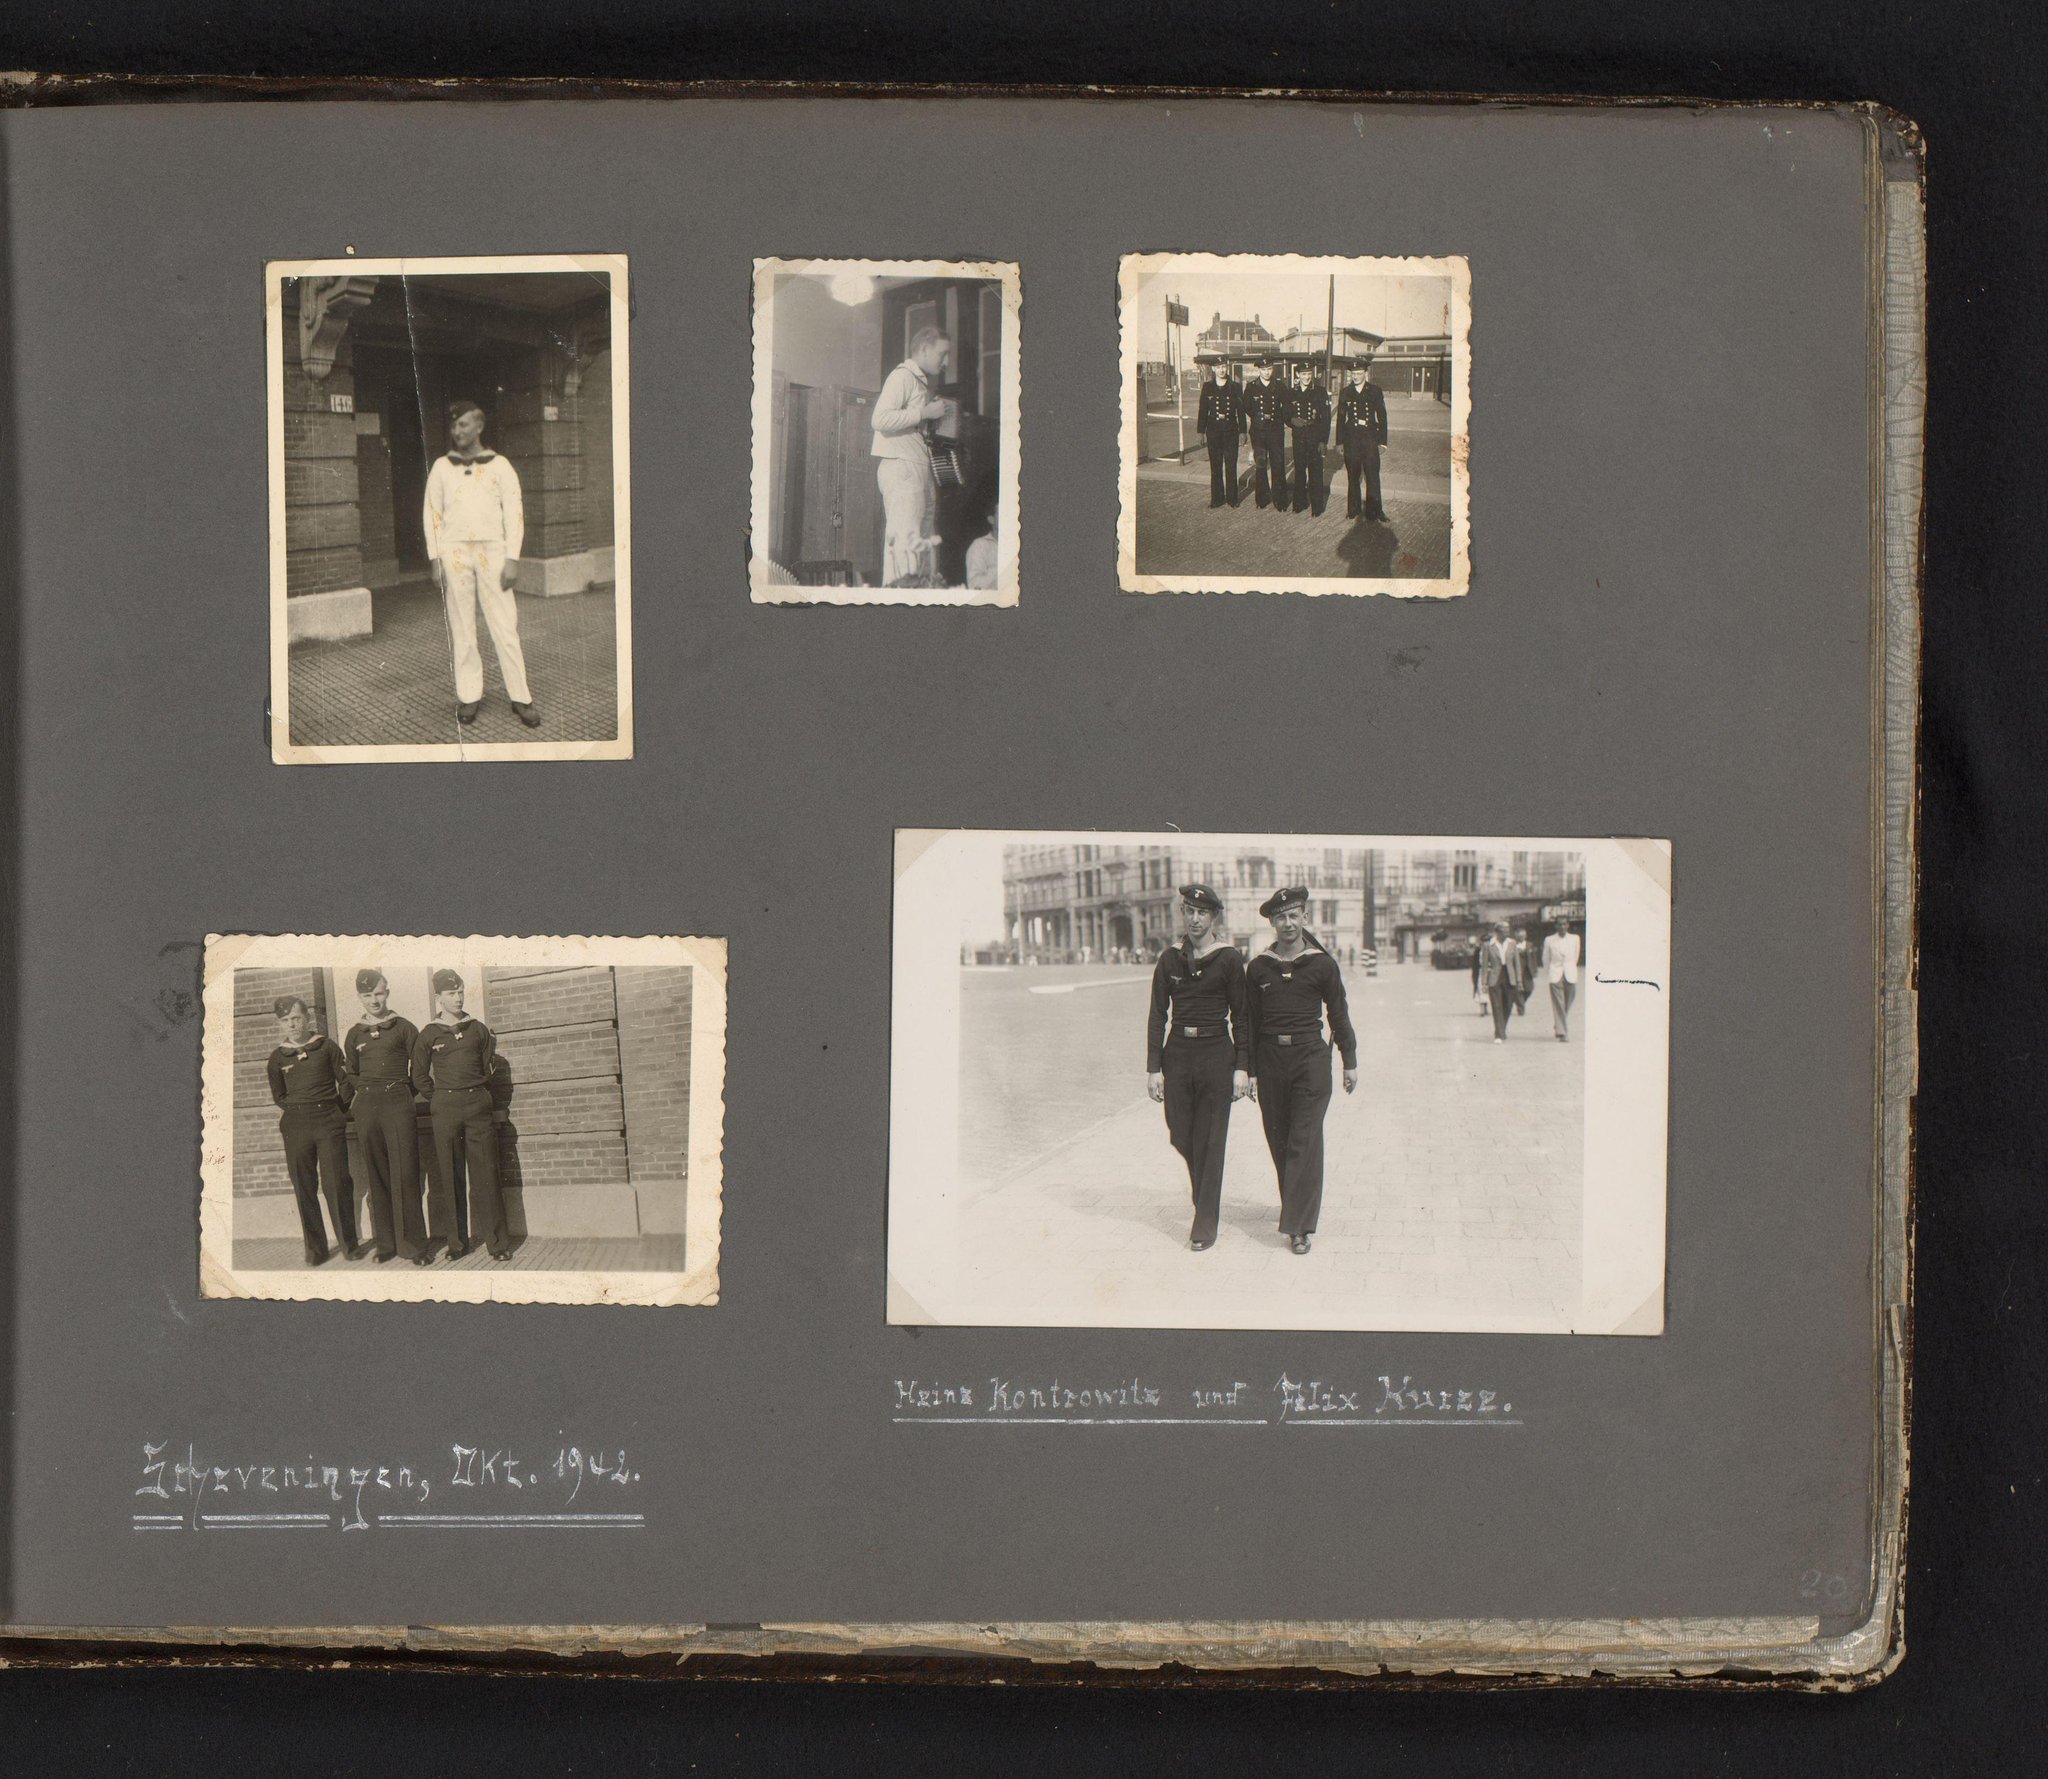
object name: album leaf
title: Kriegsmarine in Scheveningen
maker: Anonymous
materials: paper, photographic support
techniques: gelatin silver print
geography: scheveningen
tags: the company, the unit, the troop ~ military service, sailor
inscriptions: inscription: ‘Scheveningen, Okt. 1942 / Heinz Kontrowitz und Felix Kurze’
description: Albumblad met vijf foto's van matrozen van de Kriegsmarine in Scheveningen in augustus-oktober 1942. Onderdeel van het fotoalbum Kriegsmarine.